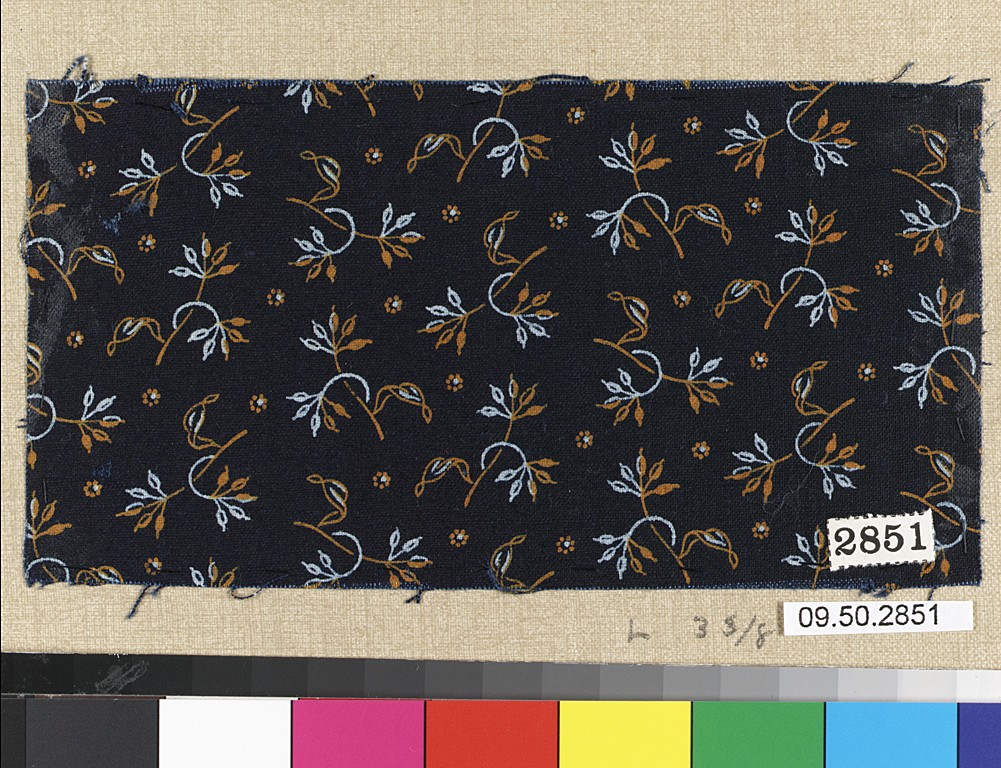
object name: piece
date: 1801-1900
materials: cotton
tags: leaves